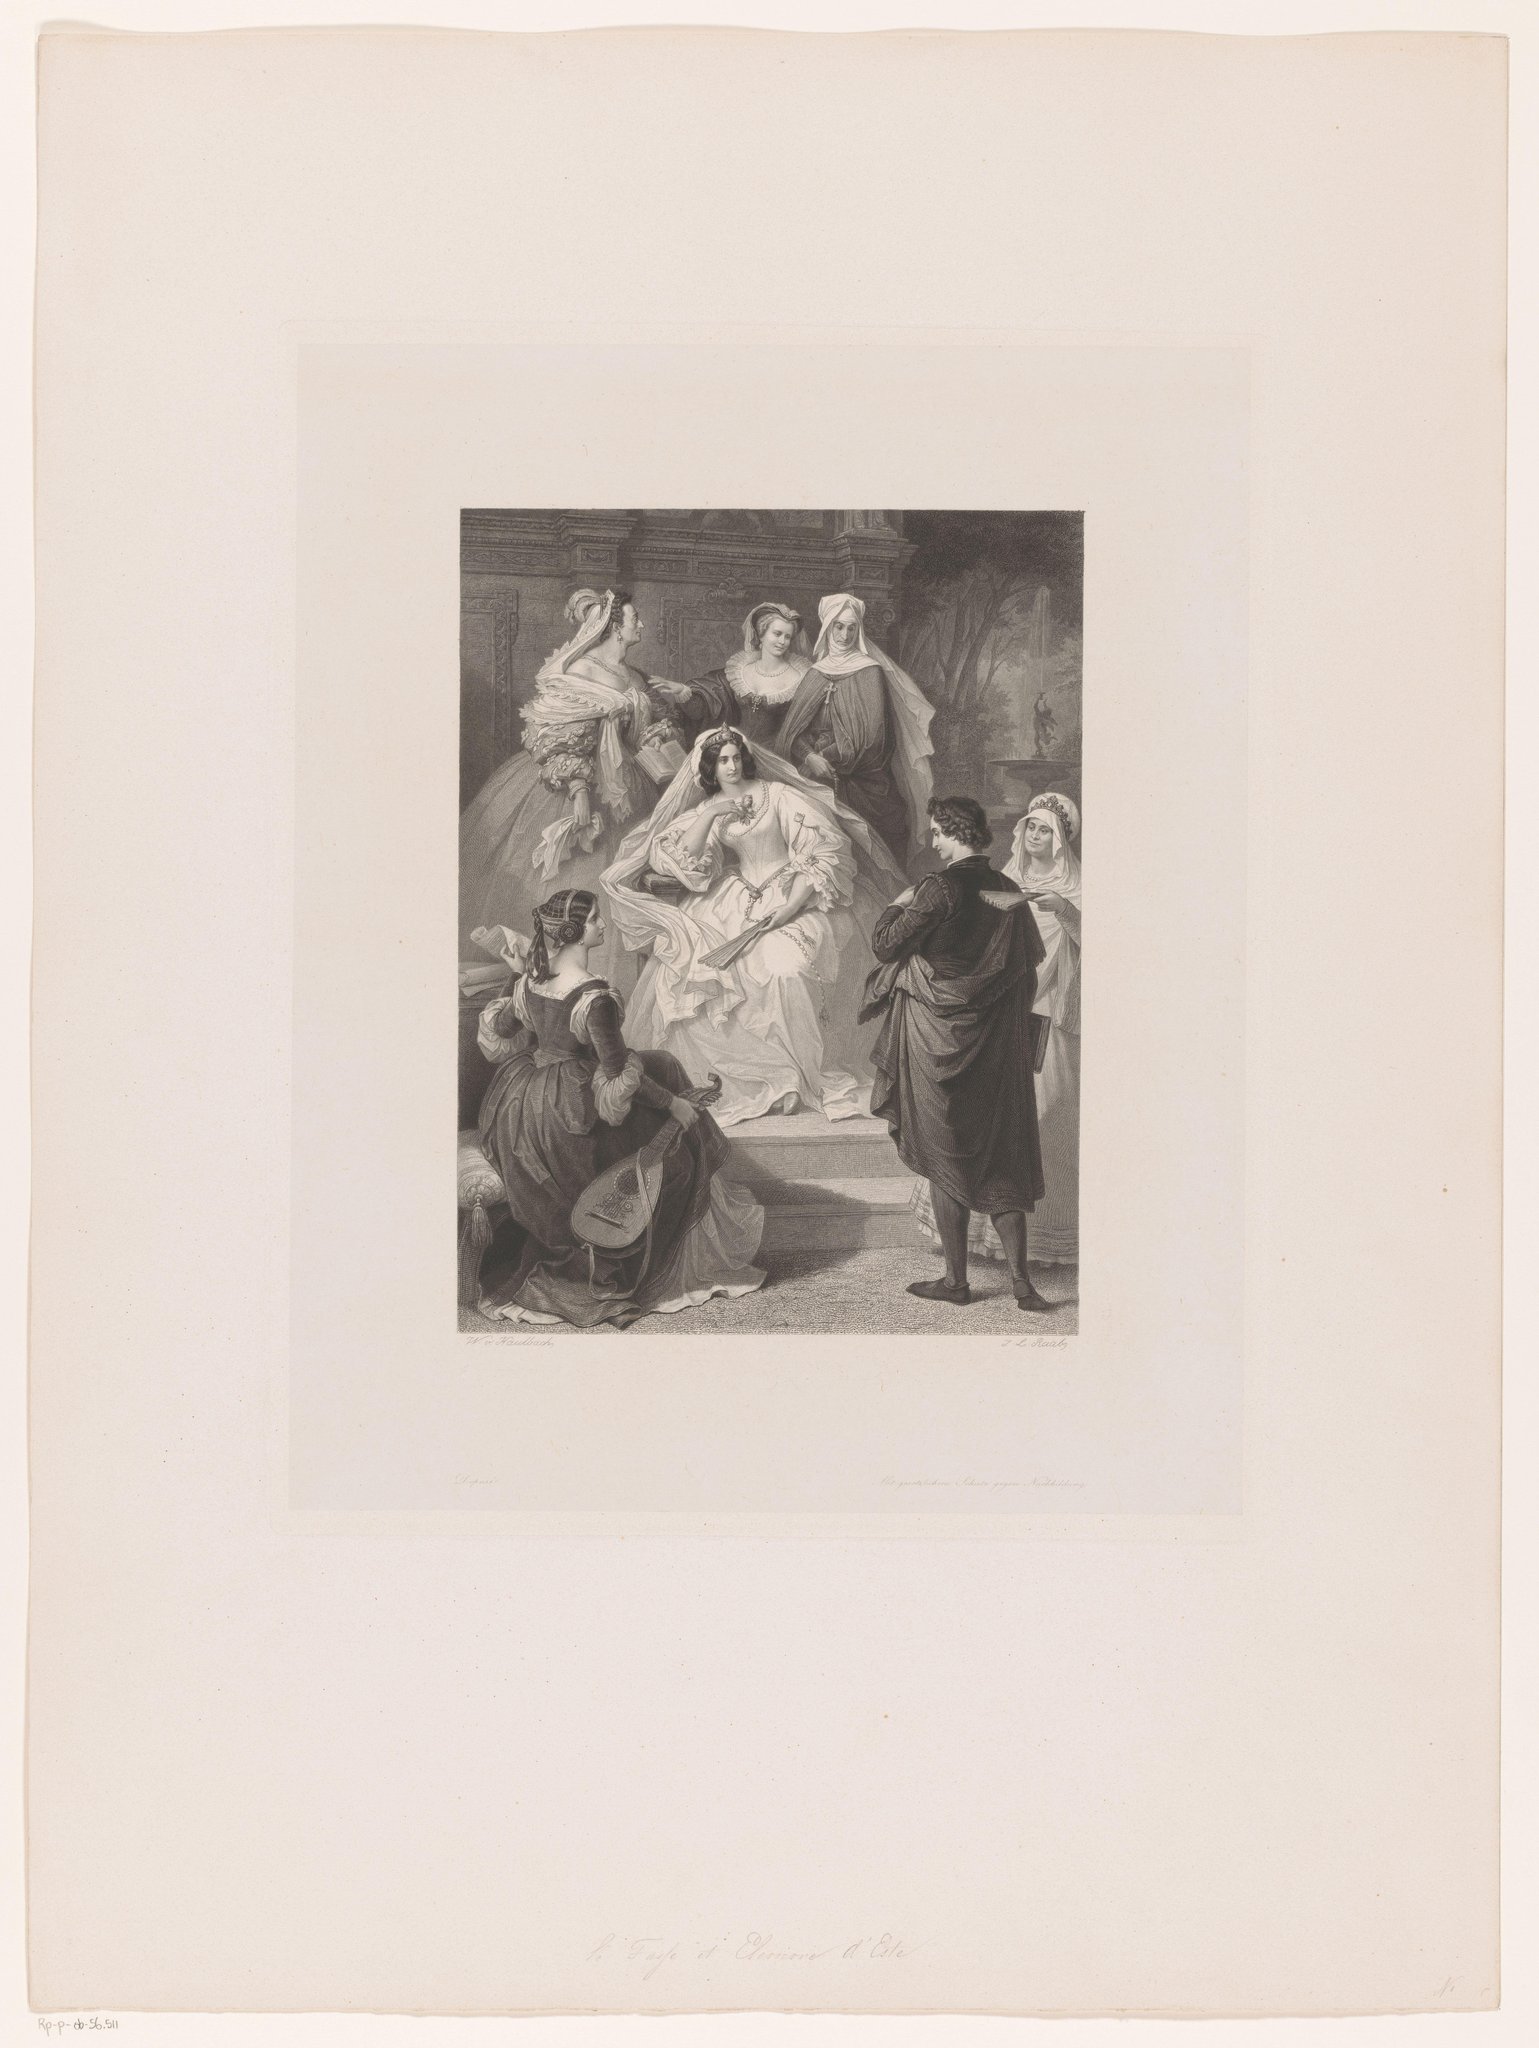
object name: print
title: Torquato Tasso voor Eleonora d'Este en haar gevolg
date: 1864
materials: paper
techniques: etching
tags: rome, torquato tasso, group of actors, troupe; actors on the stage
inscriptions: collector's mark: Lugt 2228, : ‘Deposé’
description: Scène uit een toneelstuk van Johann Wolfgang von Goethe.